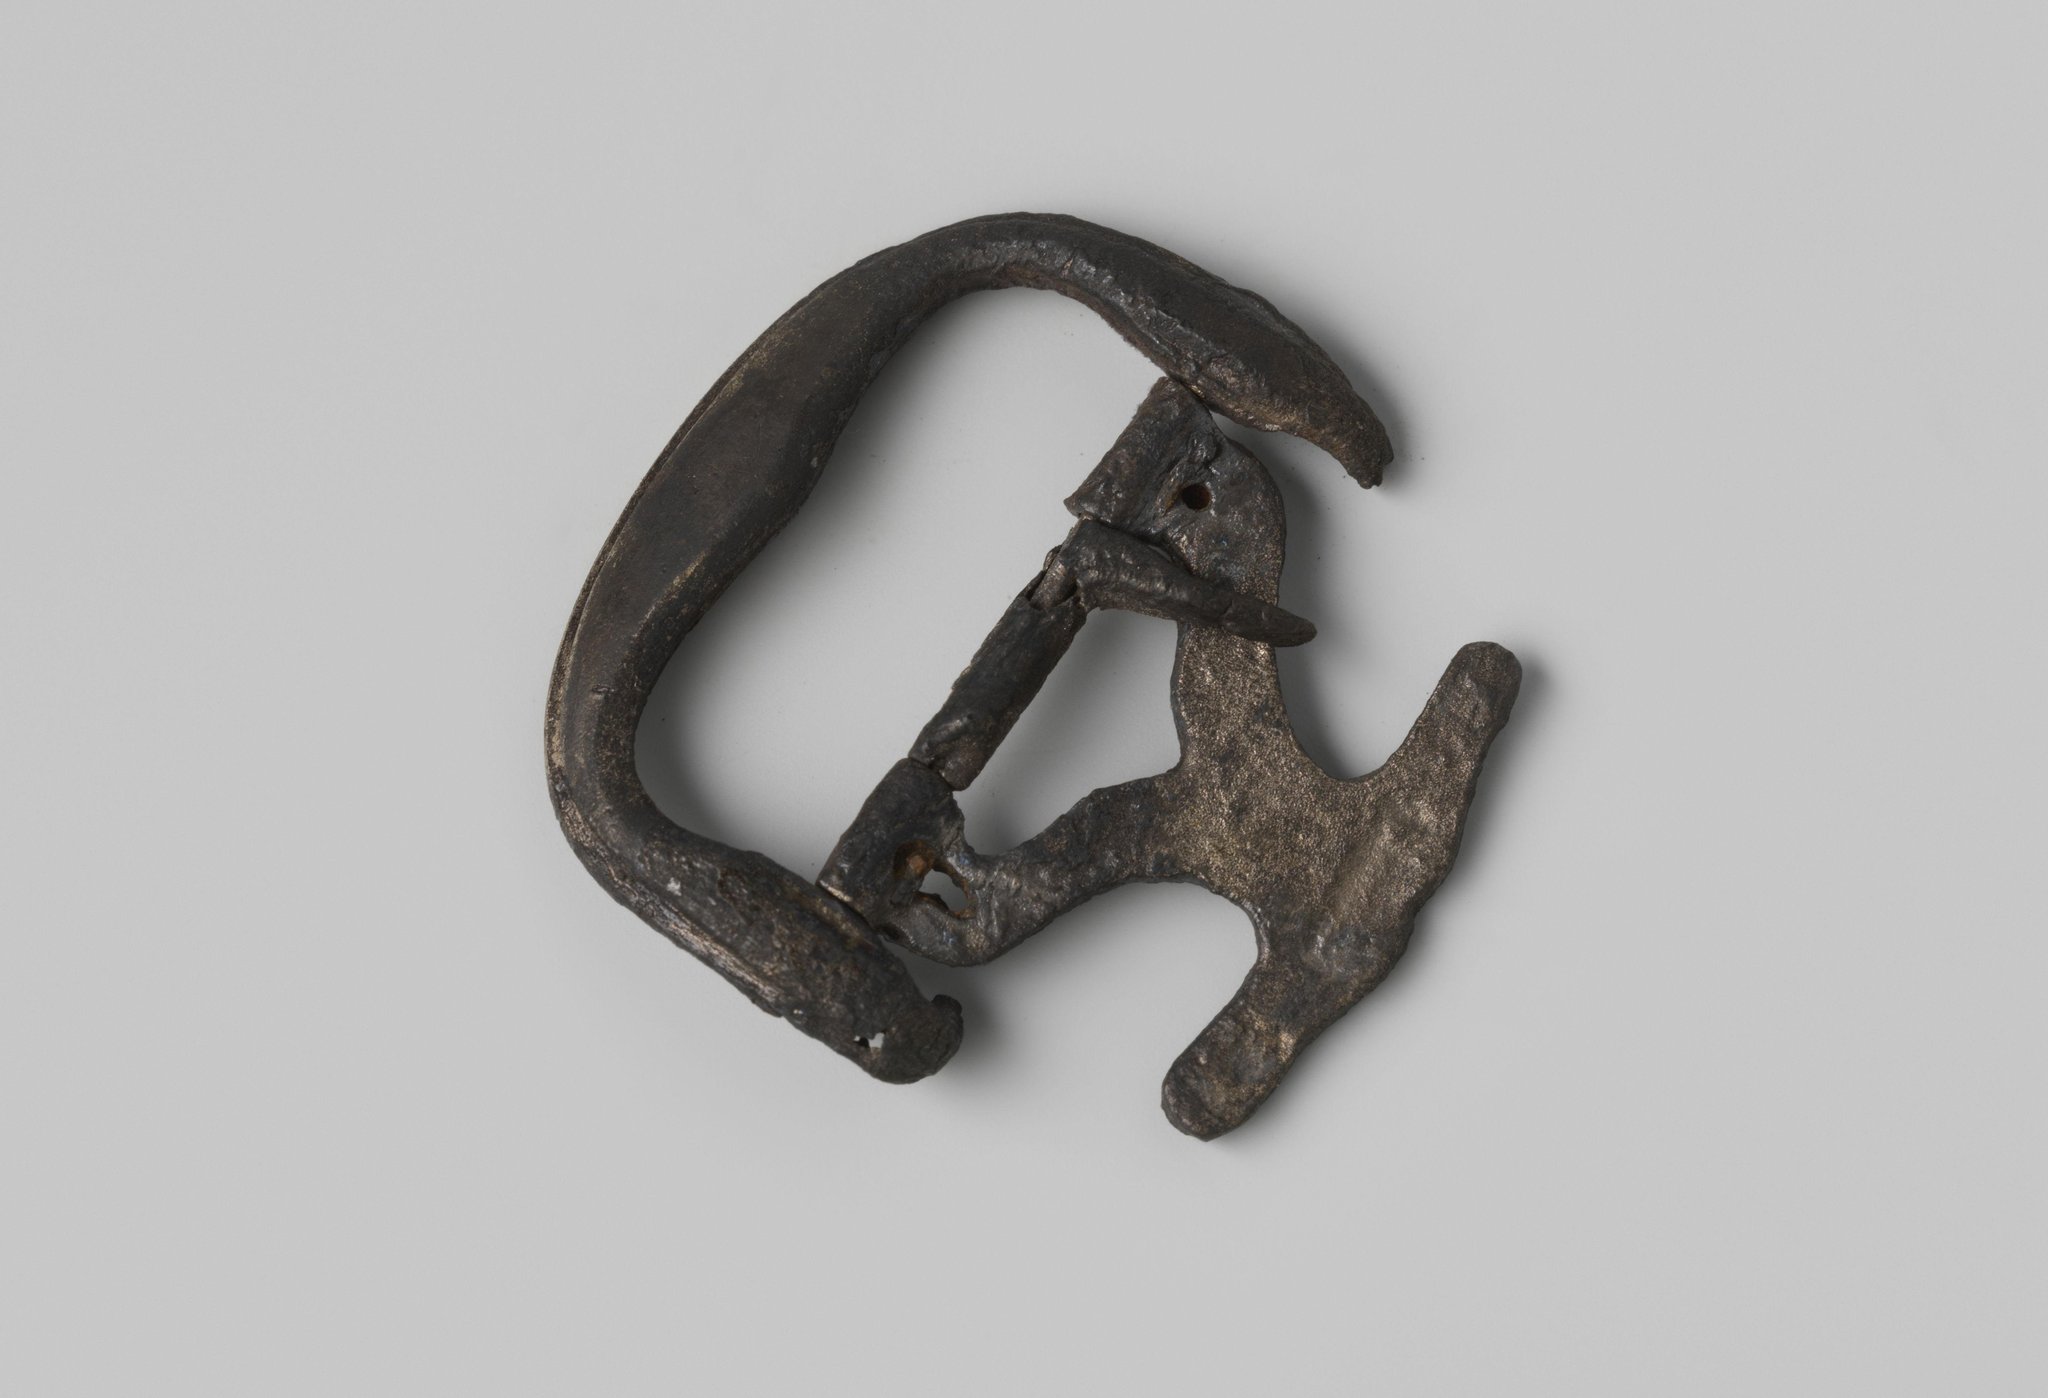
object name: shoe buckle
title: Schoengesp uit het wrak van de Oost-Indiëvaarder Hollandia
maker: Anonymous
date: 1700-1743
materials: silver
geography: netherlands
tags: verenigde oostindische compagnie, hollandia (schip), annet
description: Buckle, chape buckle, shoe buckle; fragment: half ring, moulded, 1 mark underneath, eroded, spindle, tongue, anchor-chape, 2 marks eroded [LI?, coat of arms of Amsterdam ?].